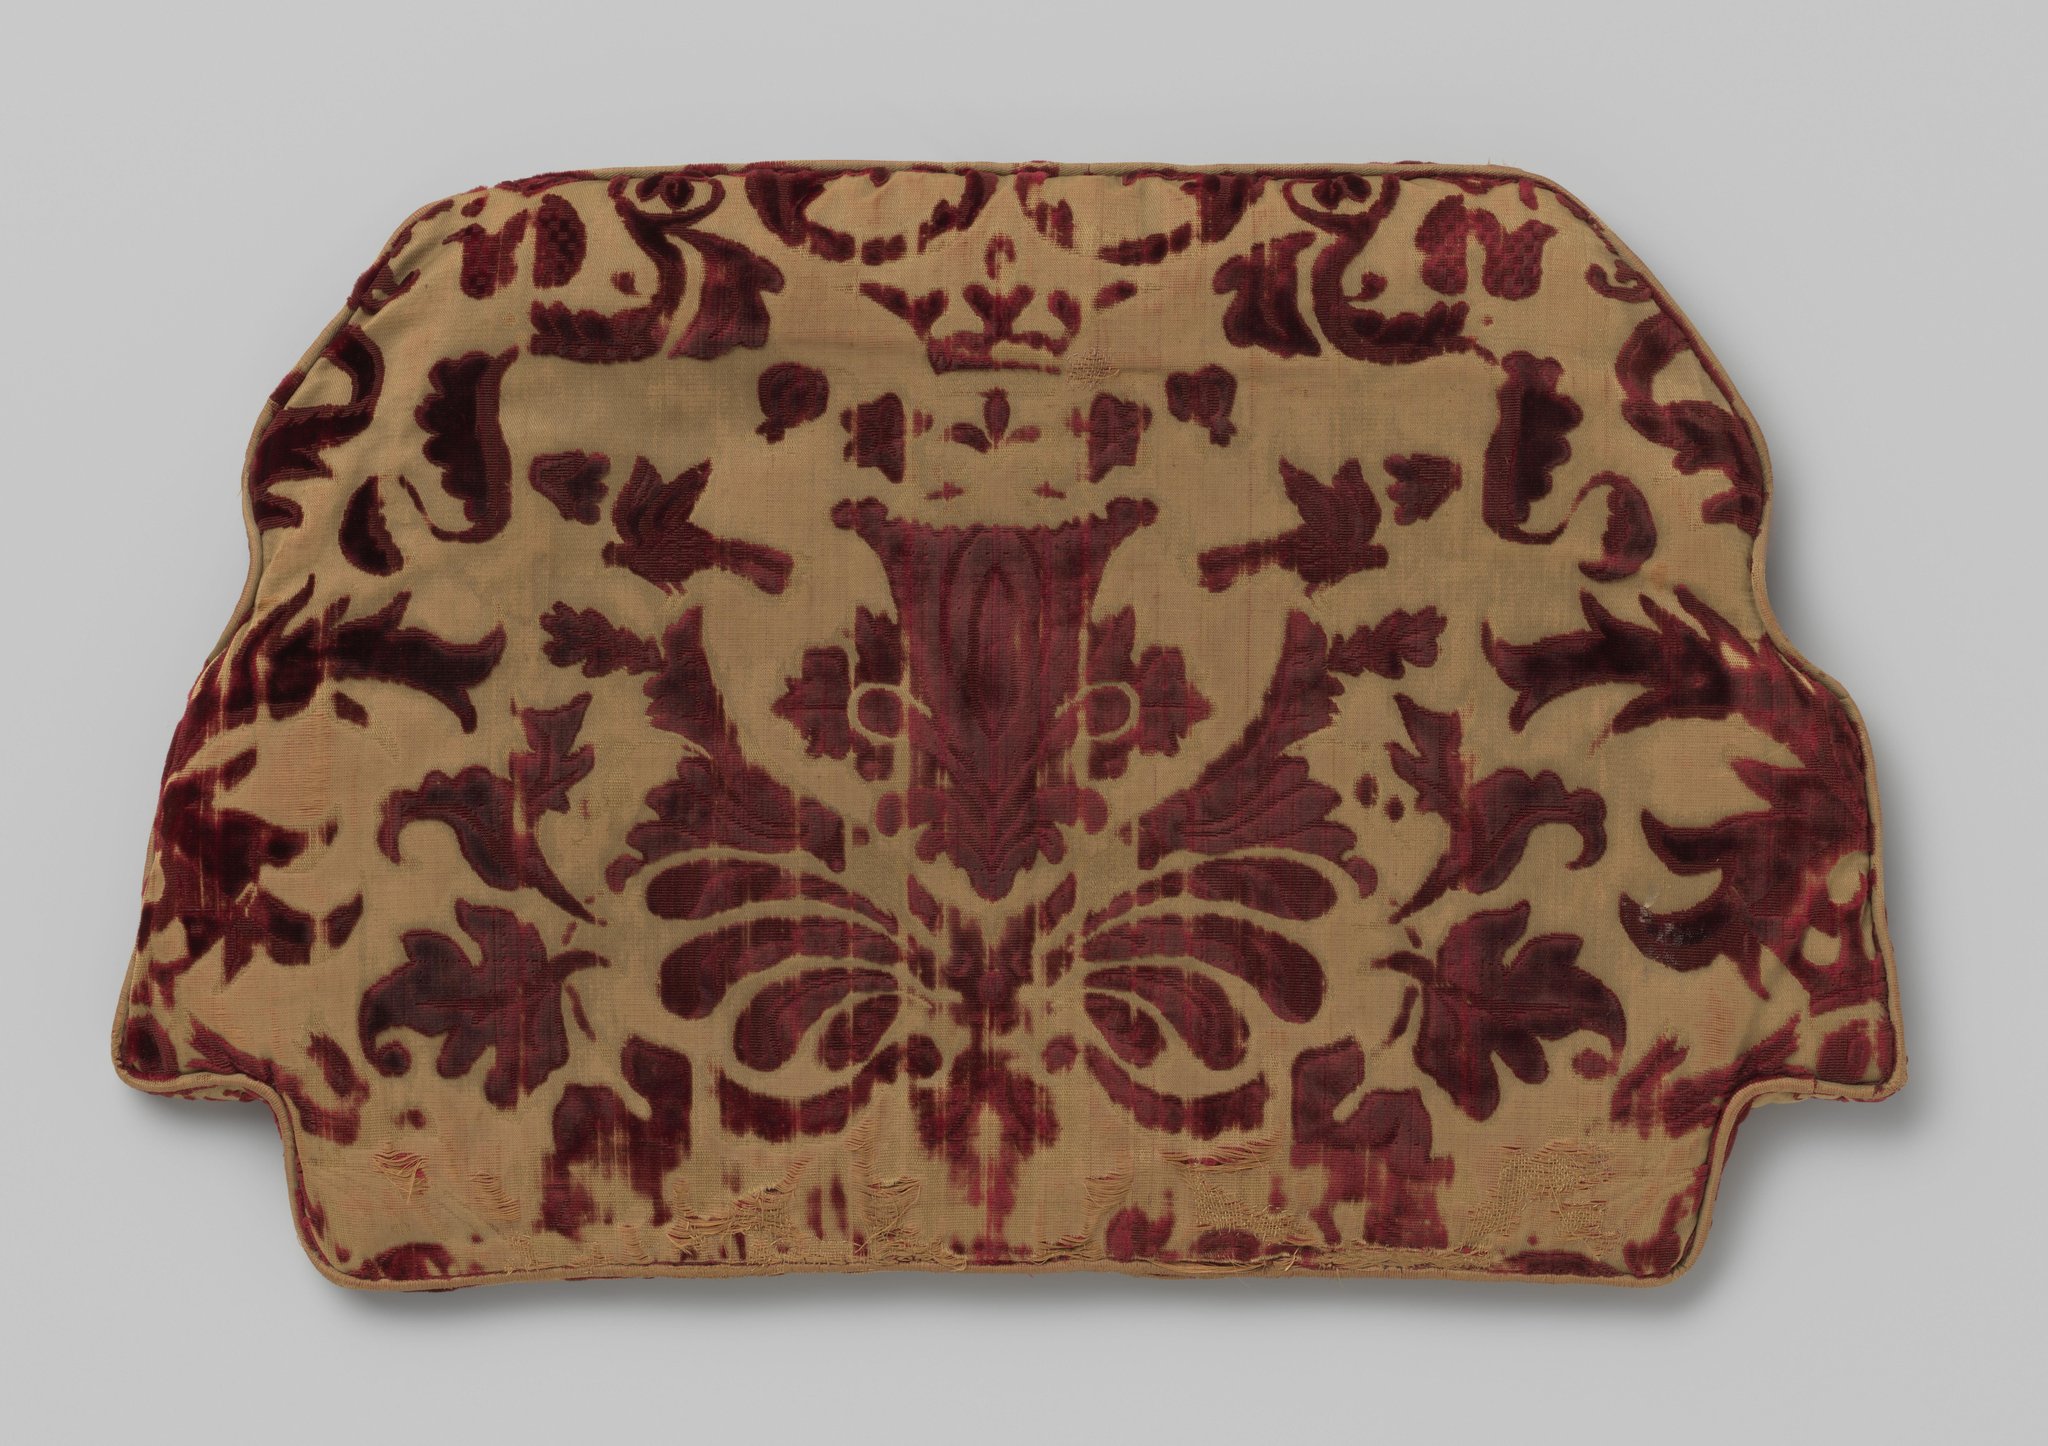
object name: stoelkussen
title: Stoelkussen van geciseleerd fluweel wijnrood op vaalgeel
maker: Anonymous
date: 1500-1599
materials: velvet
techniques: metalworking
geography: italy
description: Stoelkussen van geciseleerd fluweel, wijnrood op vaalgeel, behorend bij armstoel BK-16846. Patroon: in het midden een staande palmet opgebouwd uit hangende kleine palmetrozet van krulmotieven, acanthusbladeren en gekroonde tulp. Het geheel omgeven met wingerd- en arabeskblad. Ter weerszijden een kleine vliegende vogel. Voorts bladranken. Vorm: trapeziumvormig met vier uithollingen voor de armleggerstutten.